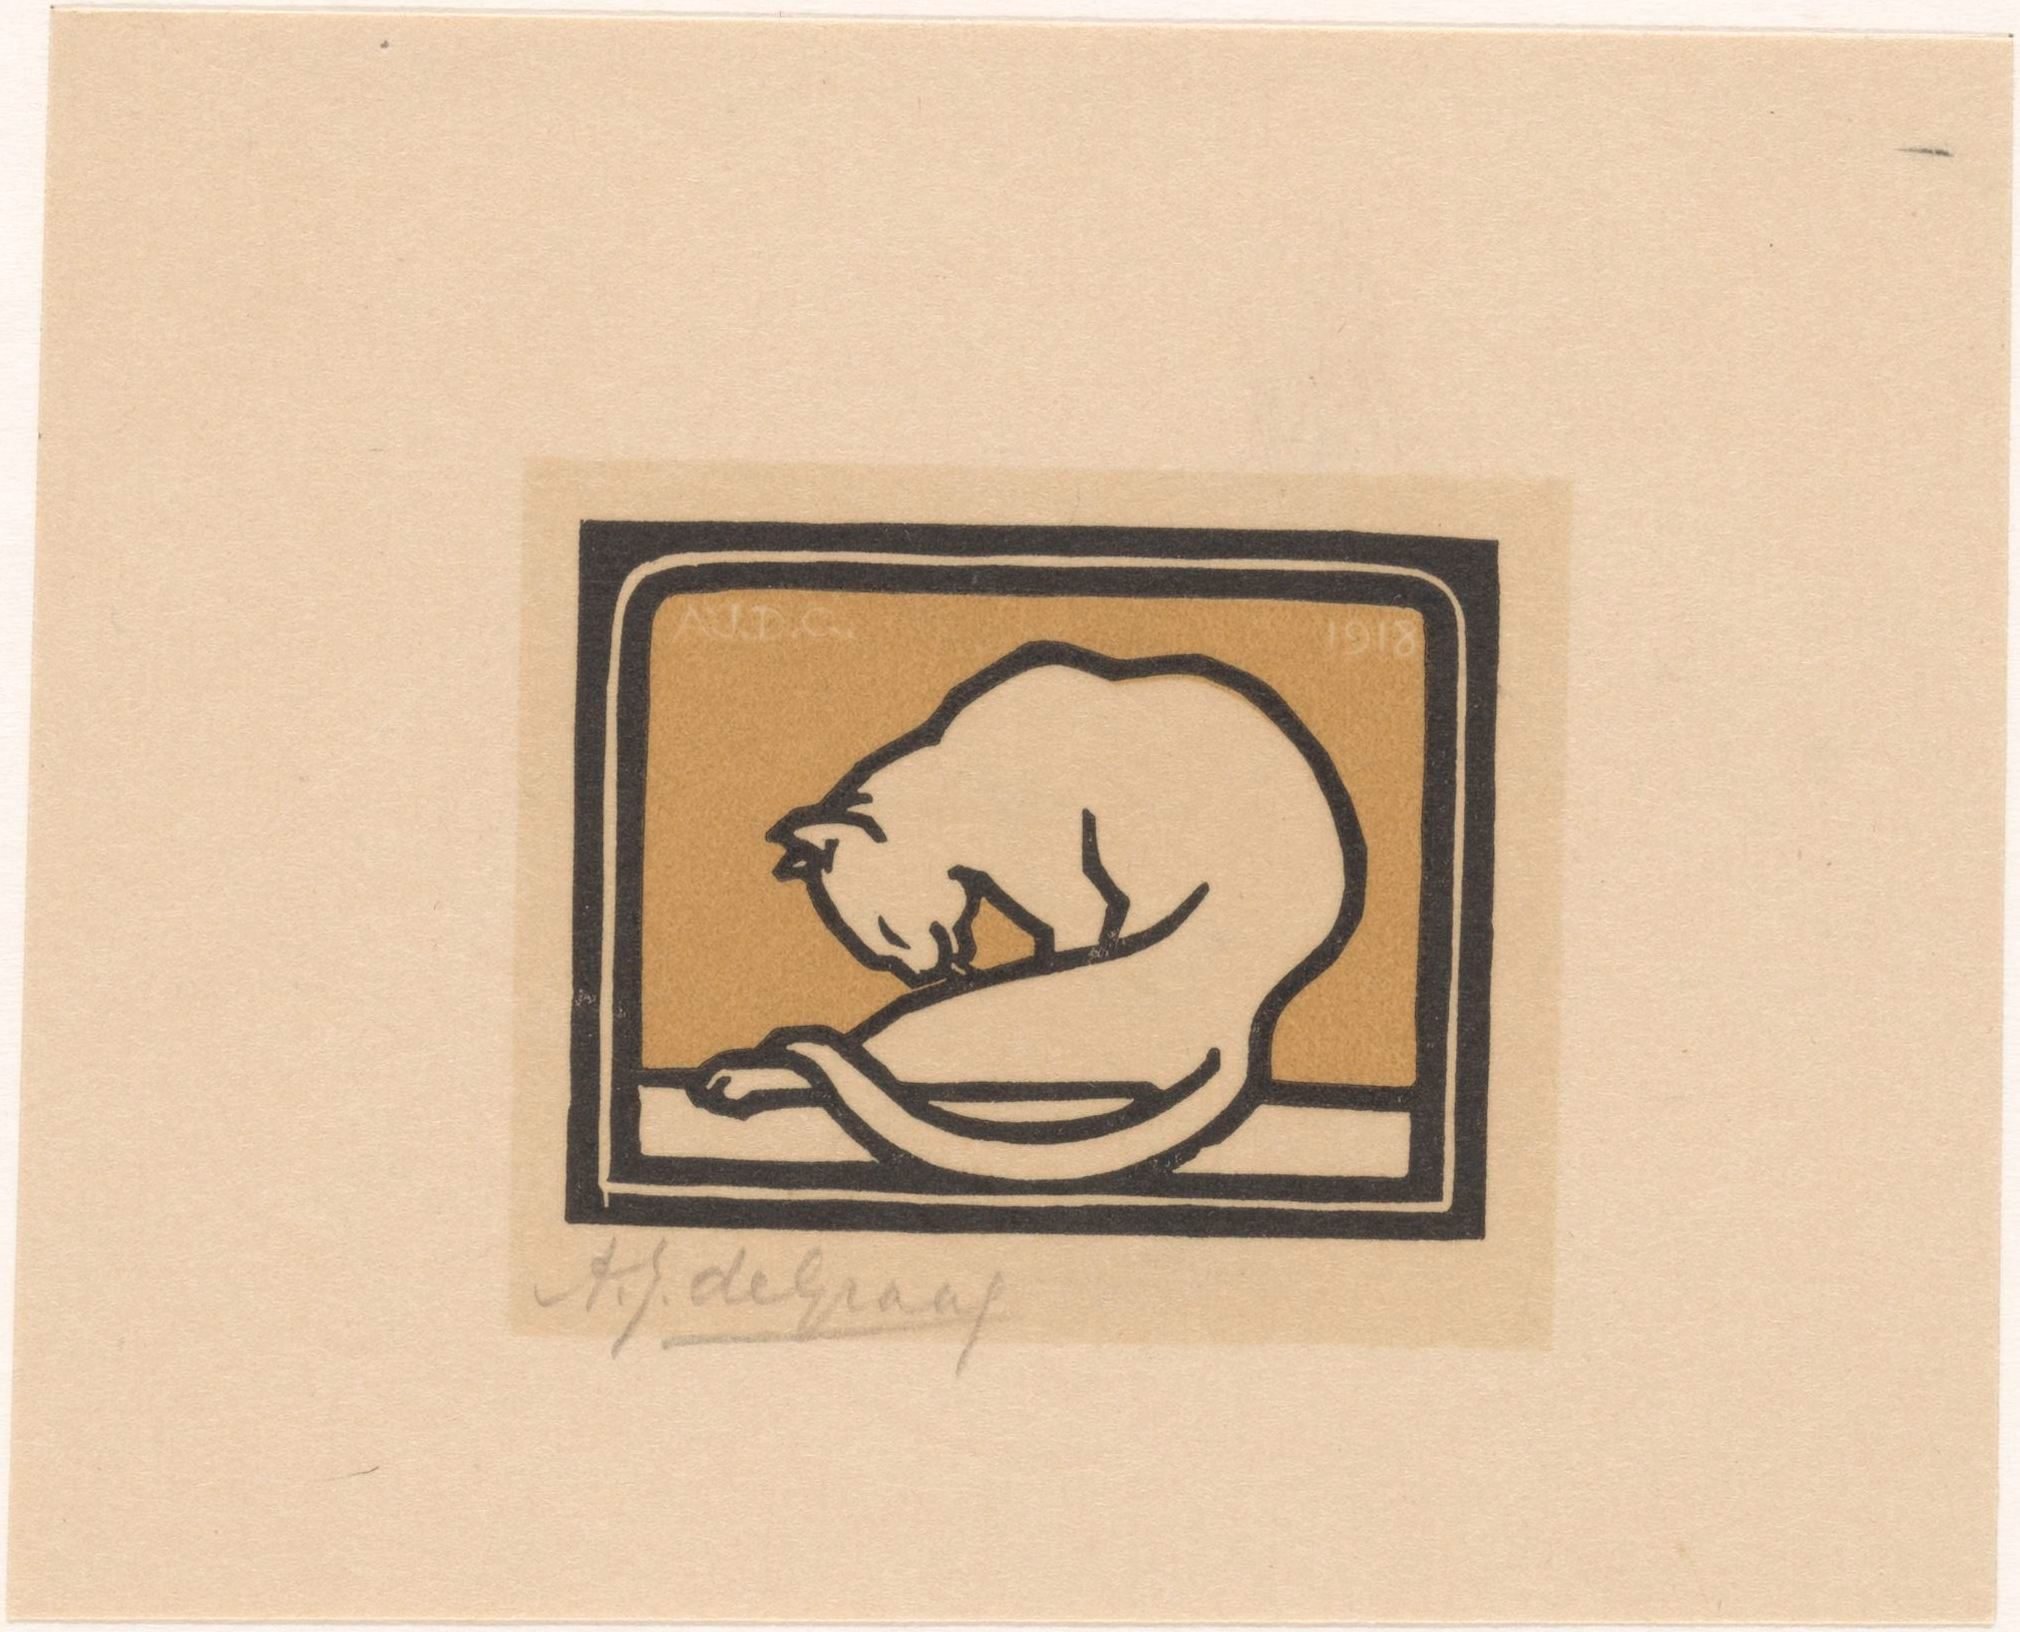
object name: print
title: Zich wassende kat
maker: julie de graag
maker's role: draughtsman, print maker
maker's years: 1877-1924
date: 1918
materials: paper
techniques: woodcut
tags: cat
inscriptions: collector's mark: Lugt 2228